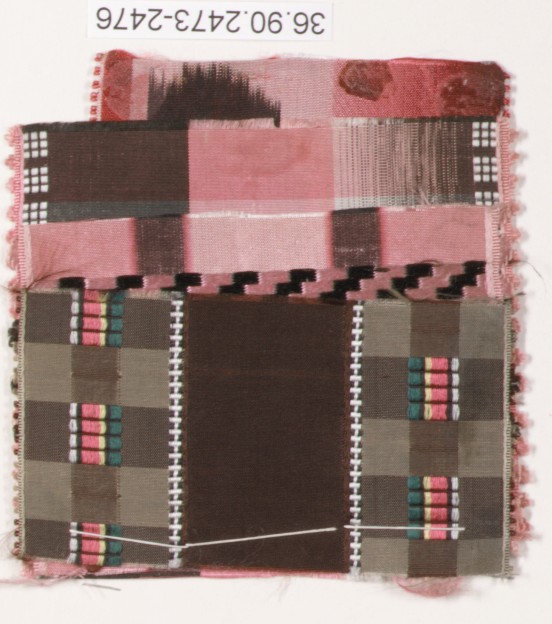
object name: ribbon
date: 1801-1900